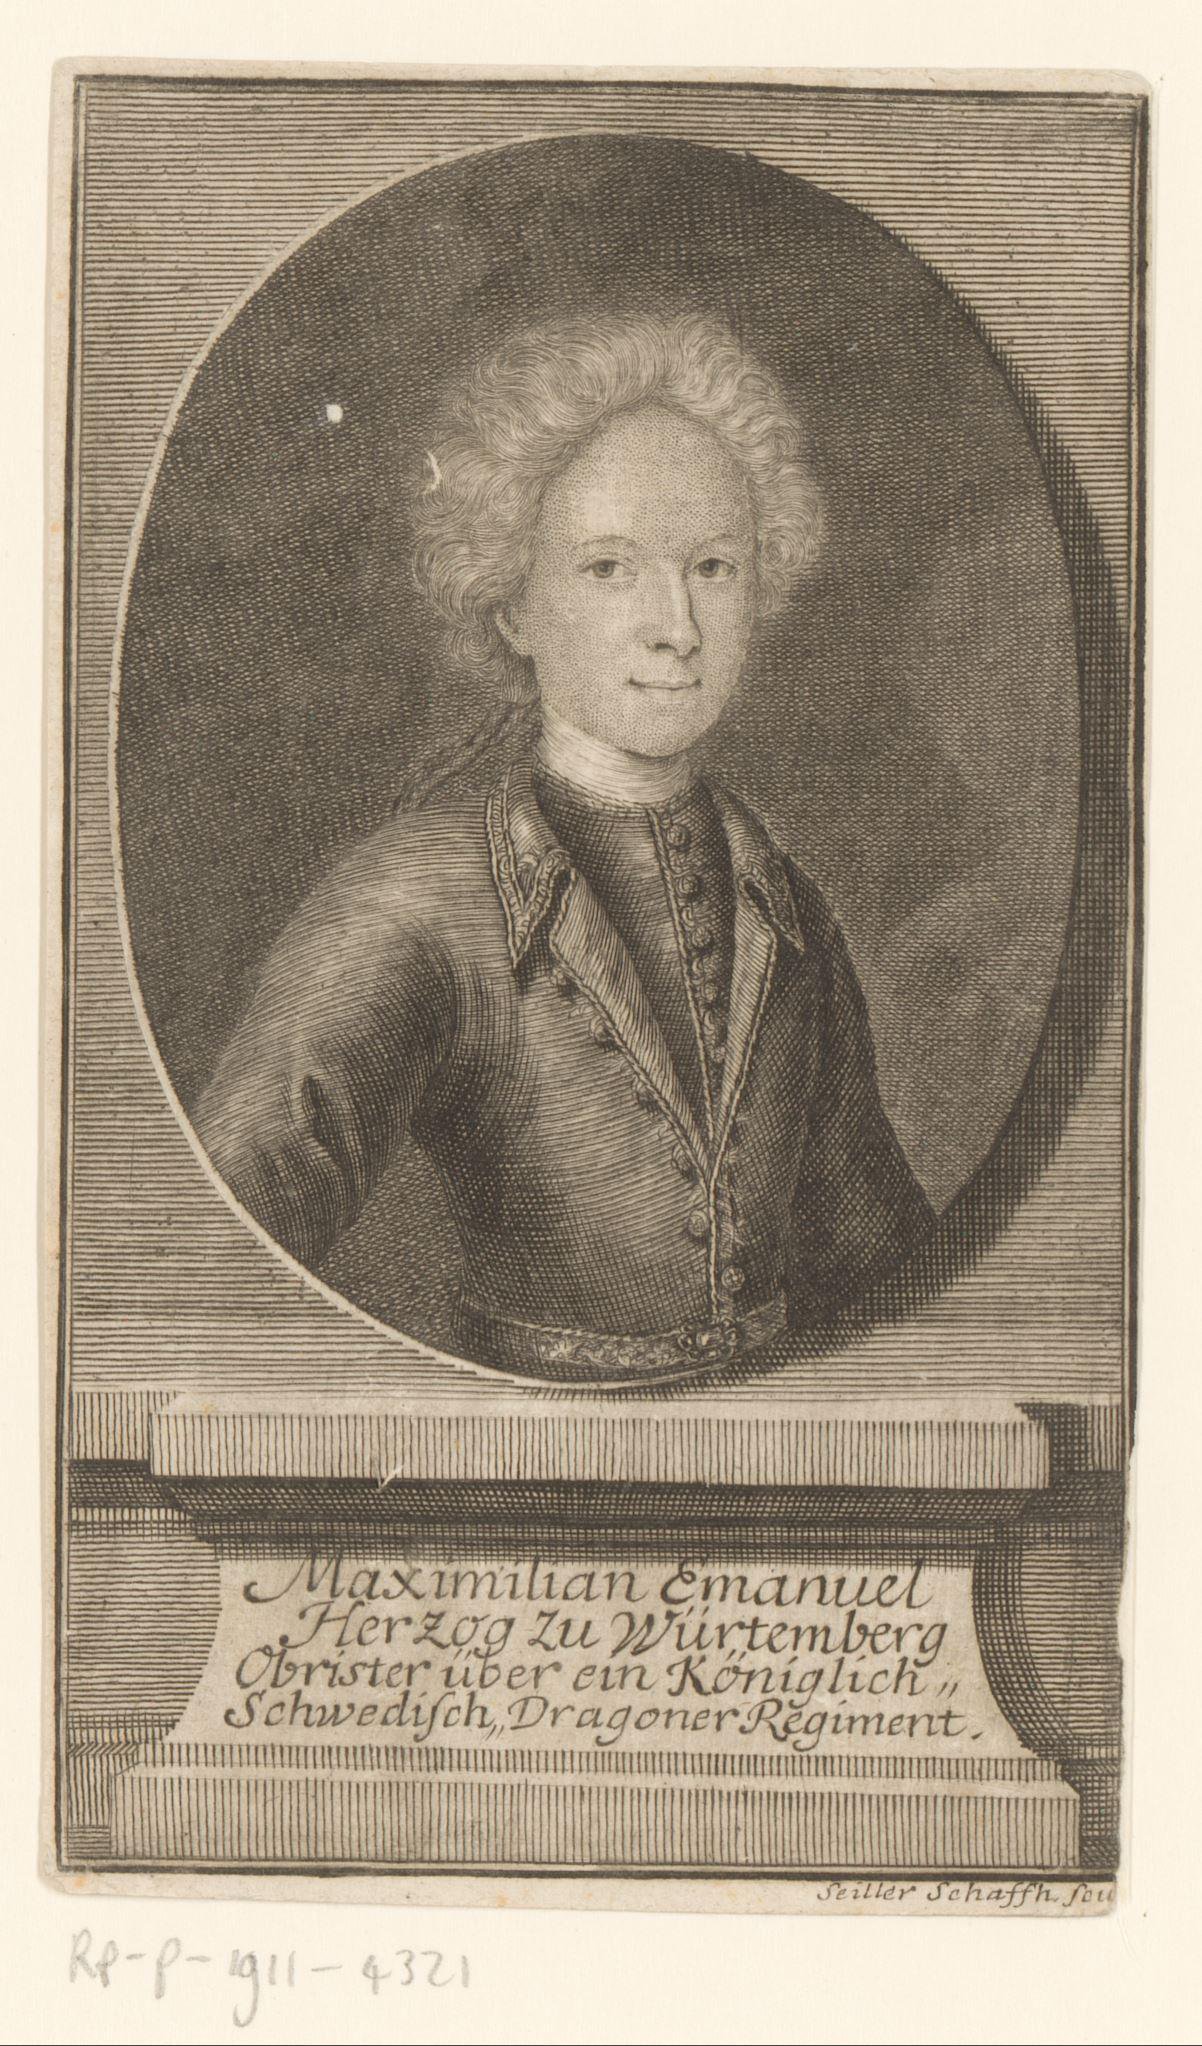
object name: print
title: Portret van Maximiliaan Emanuel von Württemberg-Winnental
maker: johann georg seiller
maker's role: print maker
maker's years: 1663-1740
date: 1699-1740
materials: paper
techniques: engraving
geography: schaffhausen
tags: historical persons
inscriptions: collector's mark: Lugt 2228